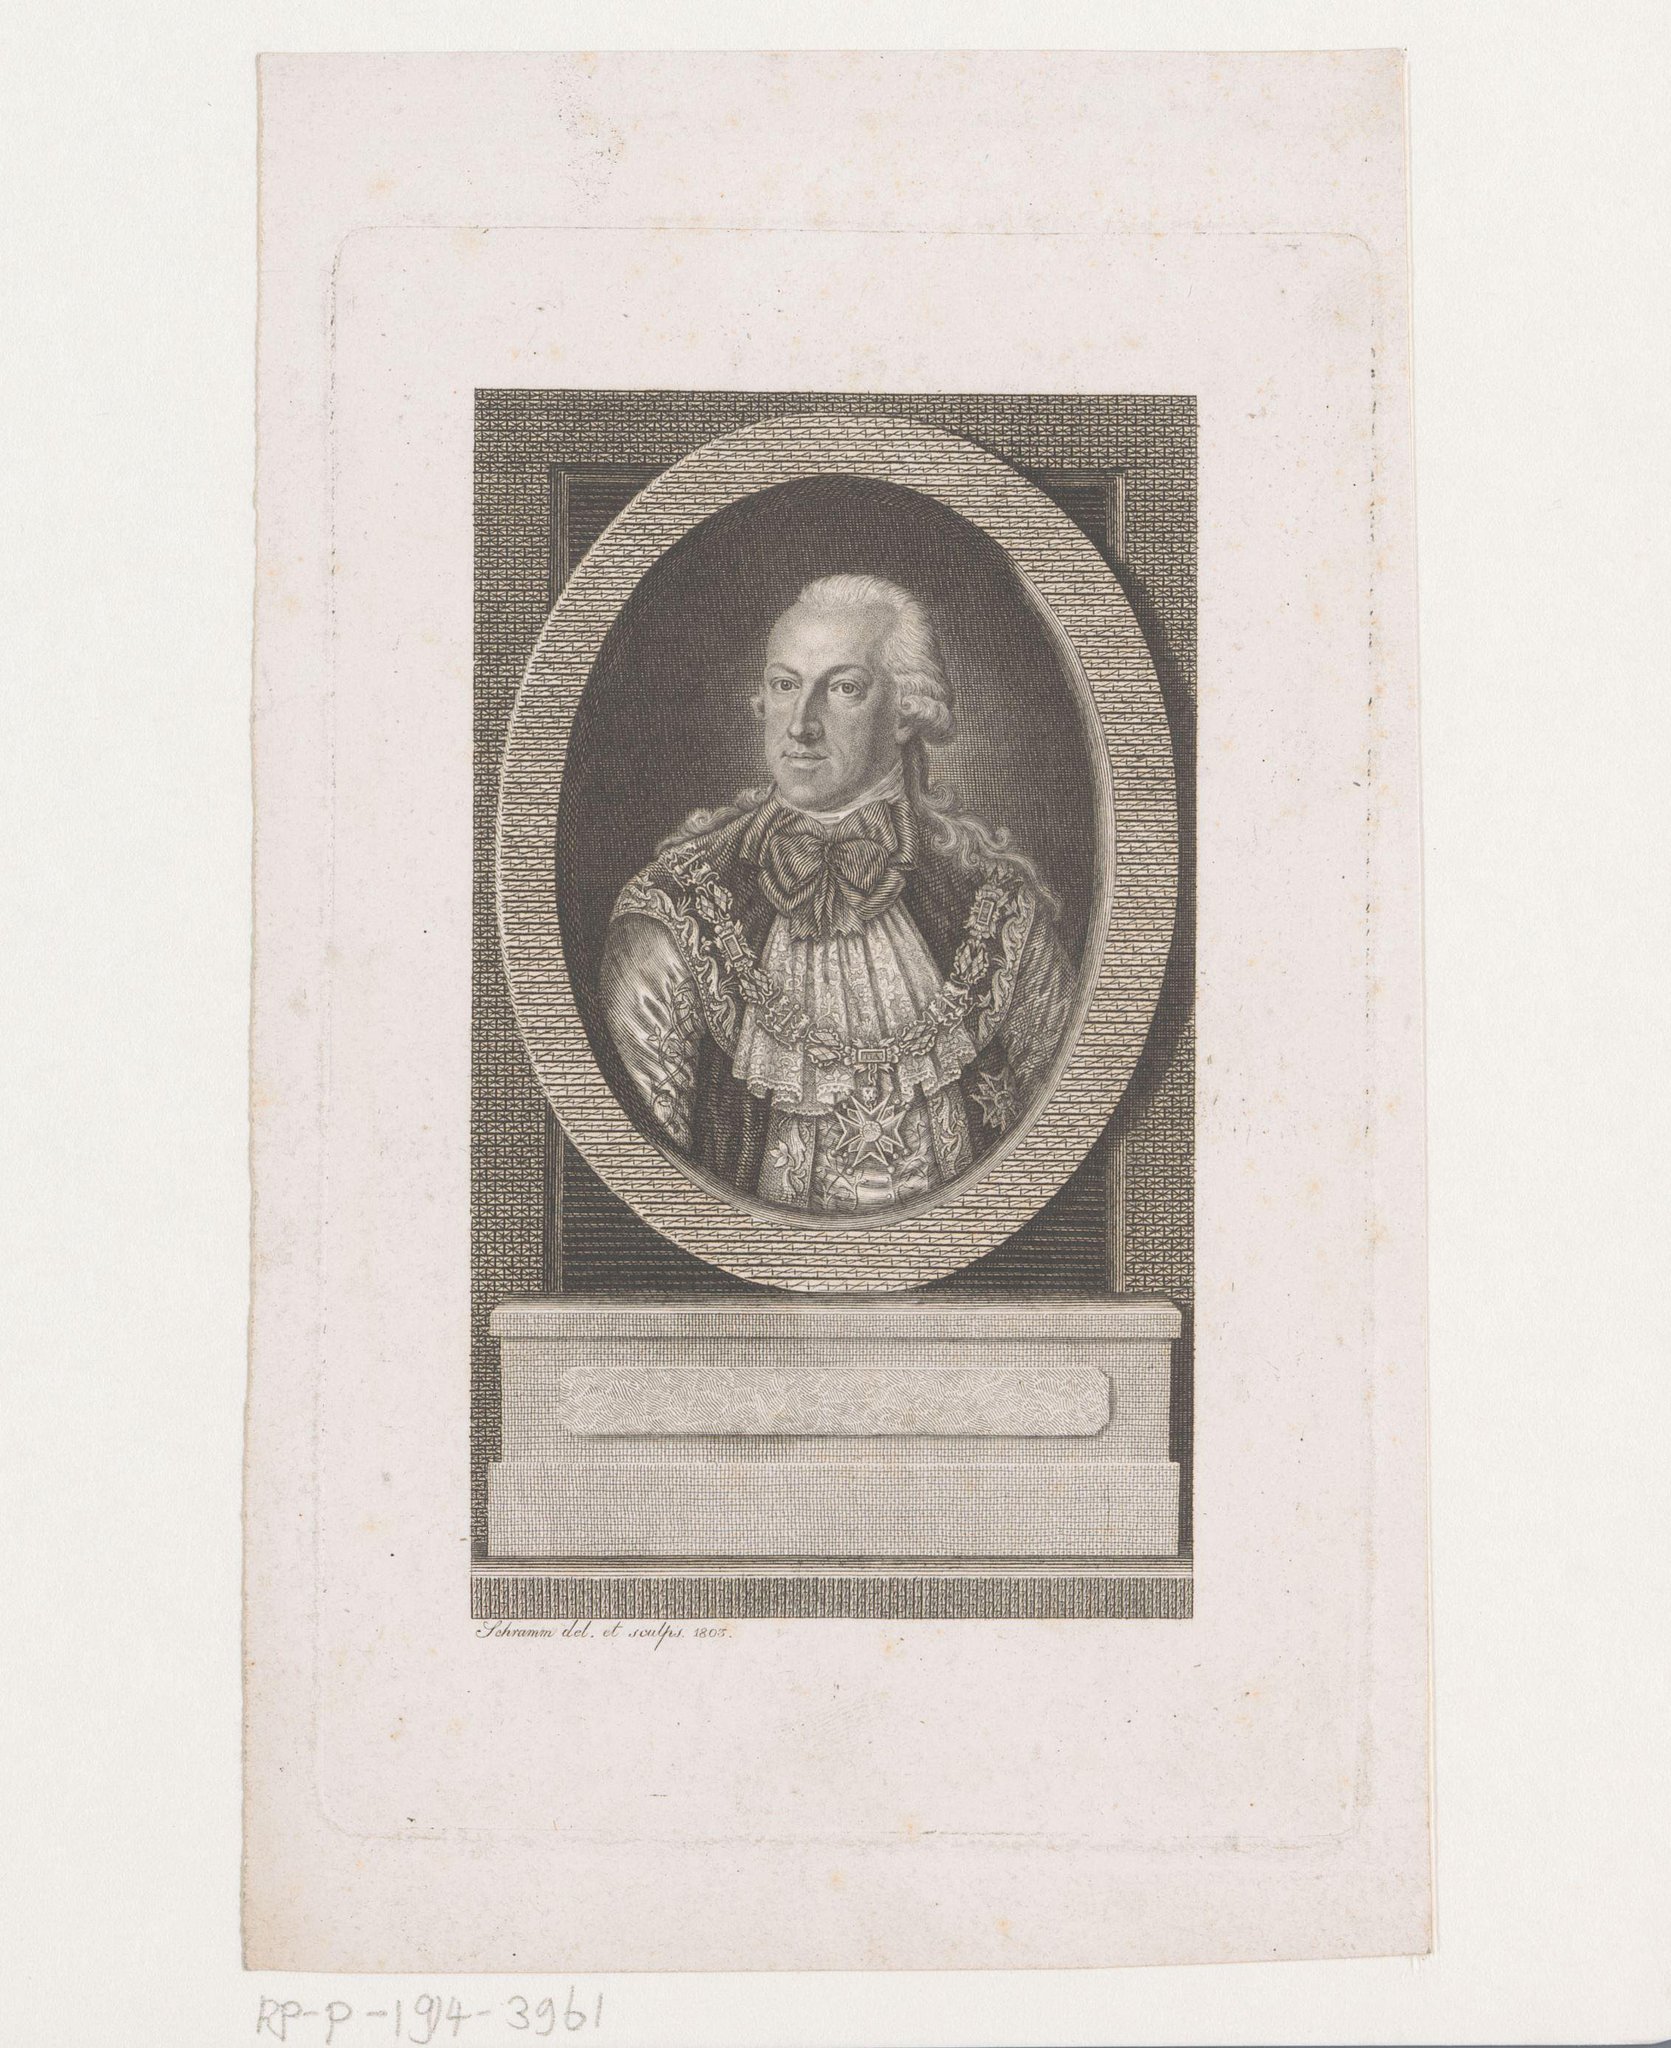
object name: print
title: Portret van Josef August von Törring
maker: johann michael schramm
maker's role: artist, print maker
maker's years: 1772-1835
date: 1835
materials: paper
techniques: engraving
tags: politician, historical persons, politician, e.g. party leader, portrait of actor, actress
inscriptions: collector's mark: Lugt 2228